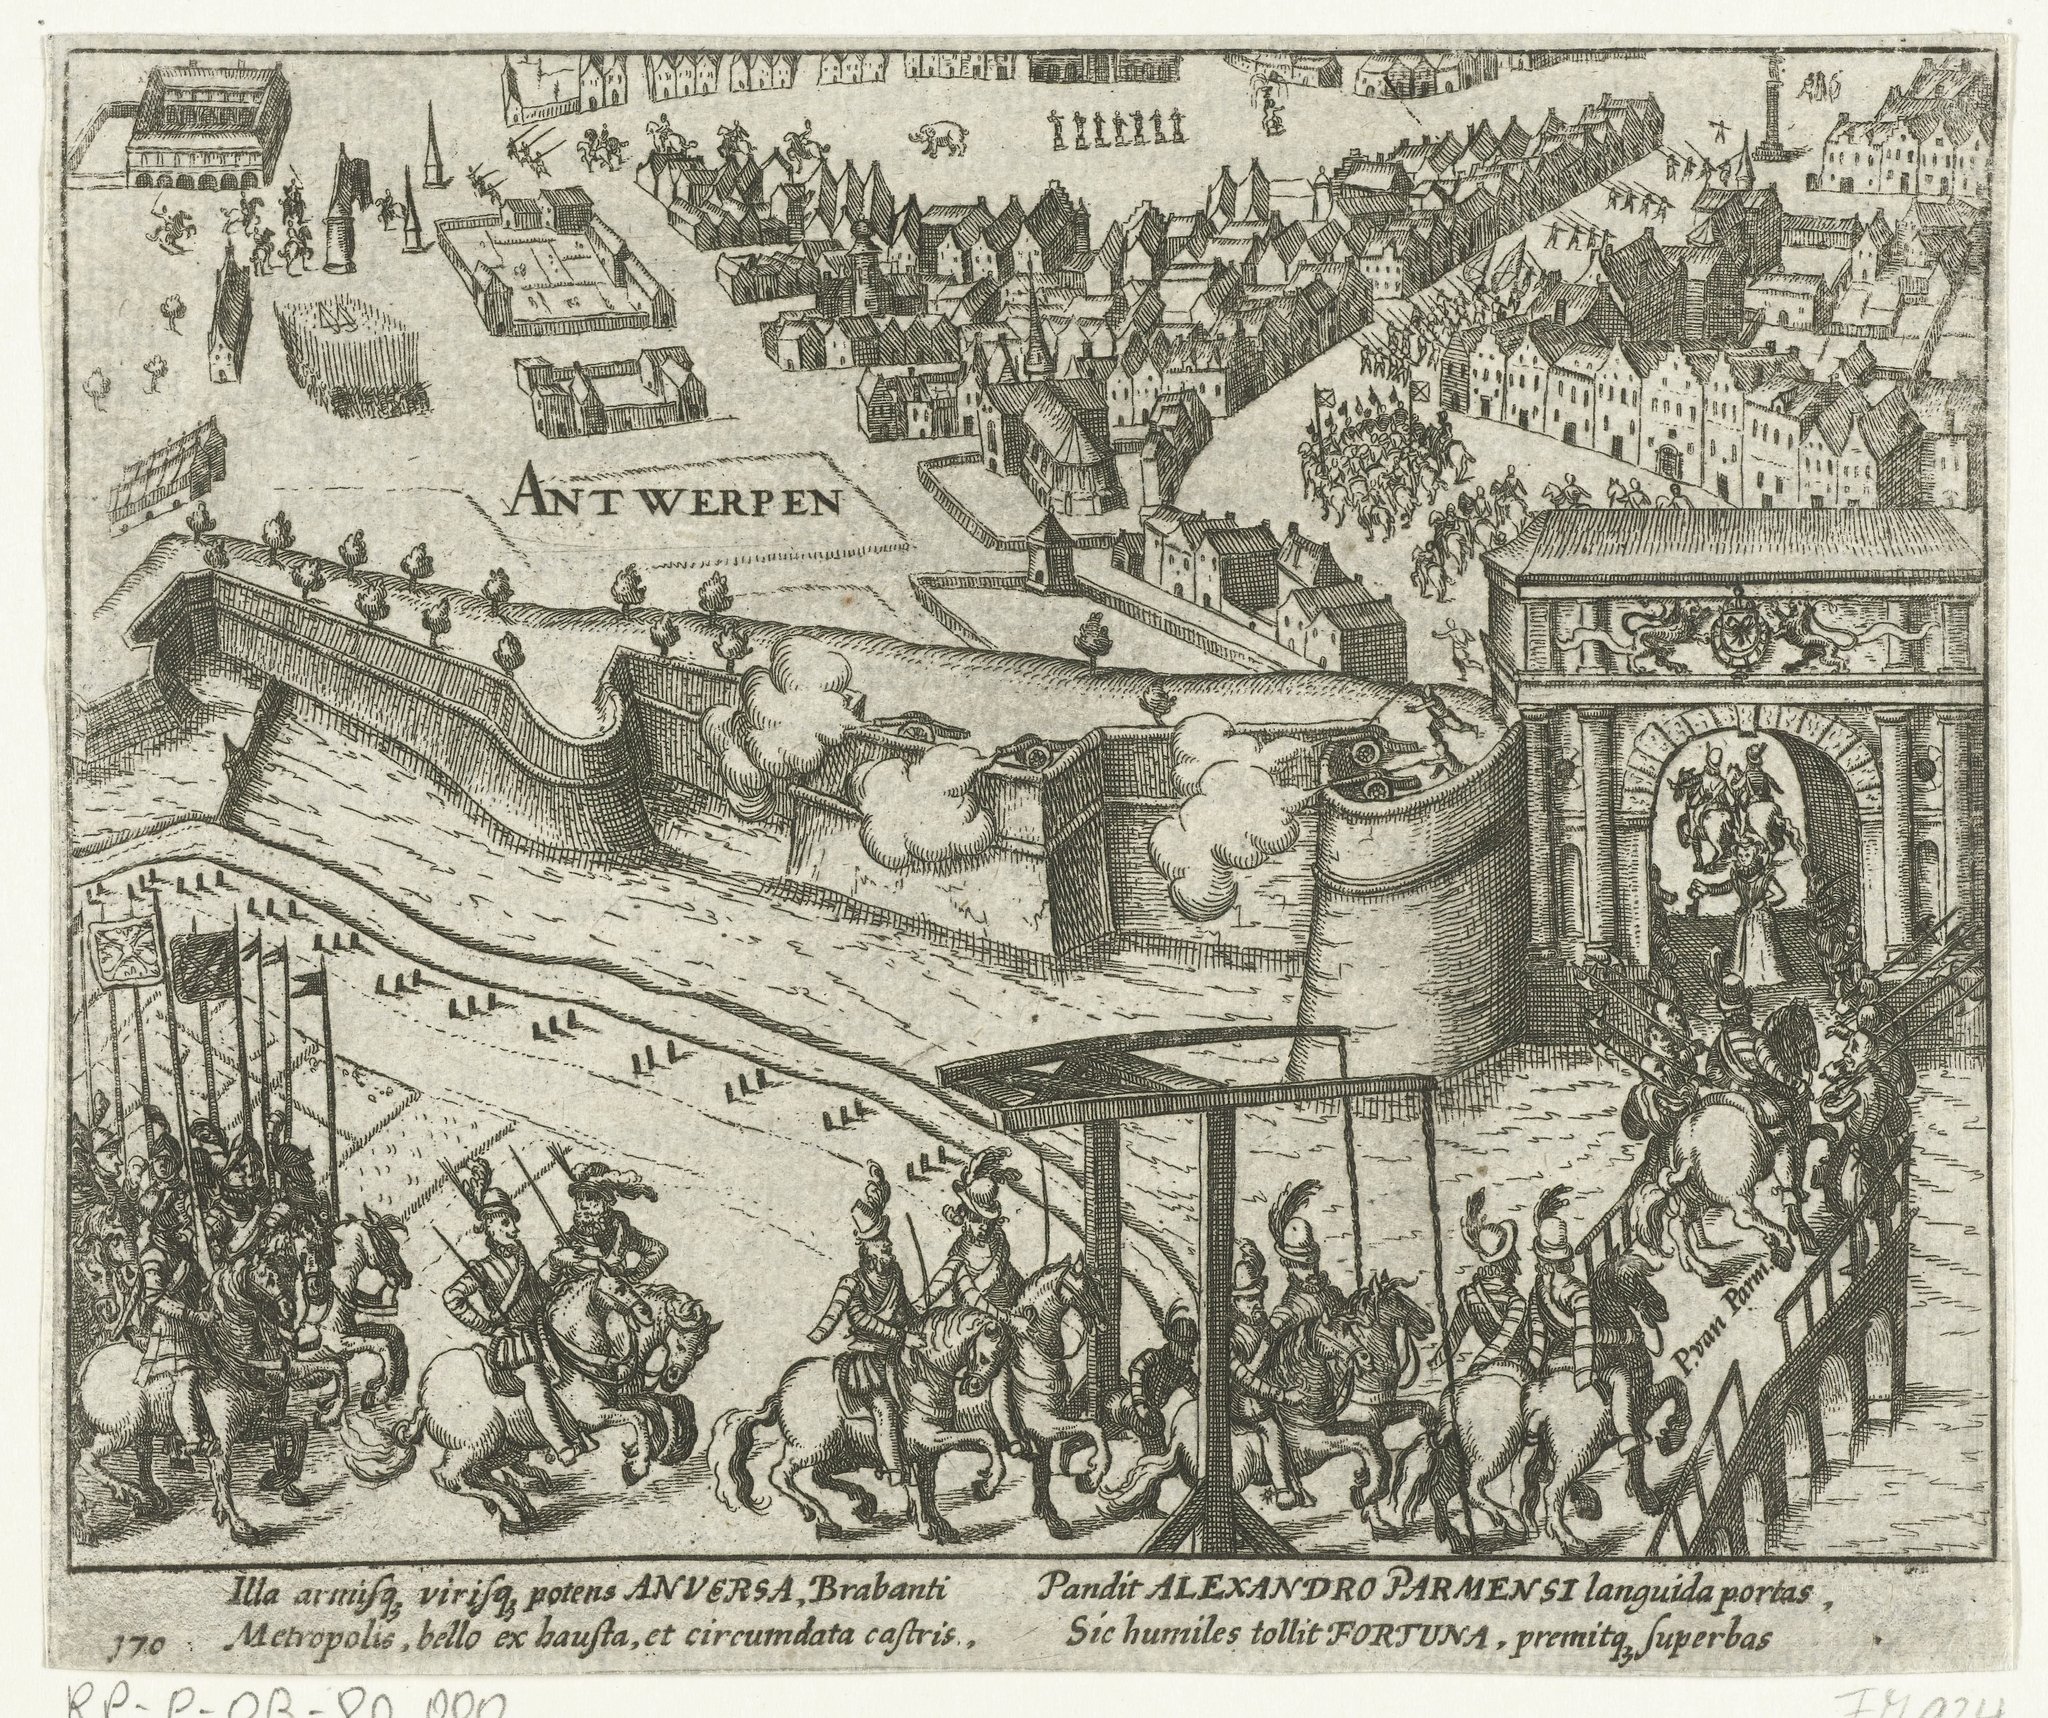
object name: print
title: Intocht van de hertog van Parma te Antwerpen, 1585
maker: Anonymous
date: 1613-1615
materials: paper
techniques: etching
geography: northern netherlands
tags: rome, alessandro farnese (landvoogd van de nederlanden en hertog van parma en piacenza), triumphal entry and public reception, pageant, 'entrée solennelle', 'joyeuse entrée', antwerp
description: Antwerpen onderwerpt zich aan Parma, 27 augustus 1585. Feestelijke intocht van de hertog van Parma te Antwerpen, met de route die de stoet door de stad aflegt. Met onderschrift van 4 regels in het Latijn. Genummerd: 170. Bedrukt op achterzijde met tekst in het Latijn.